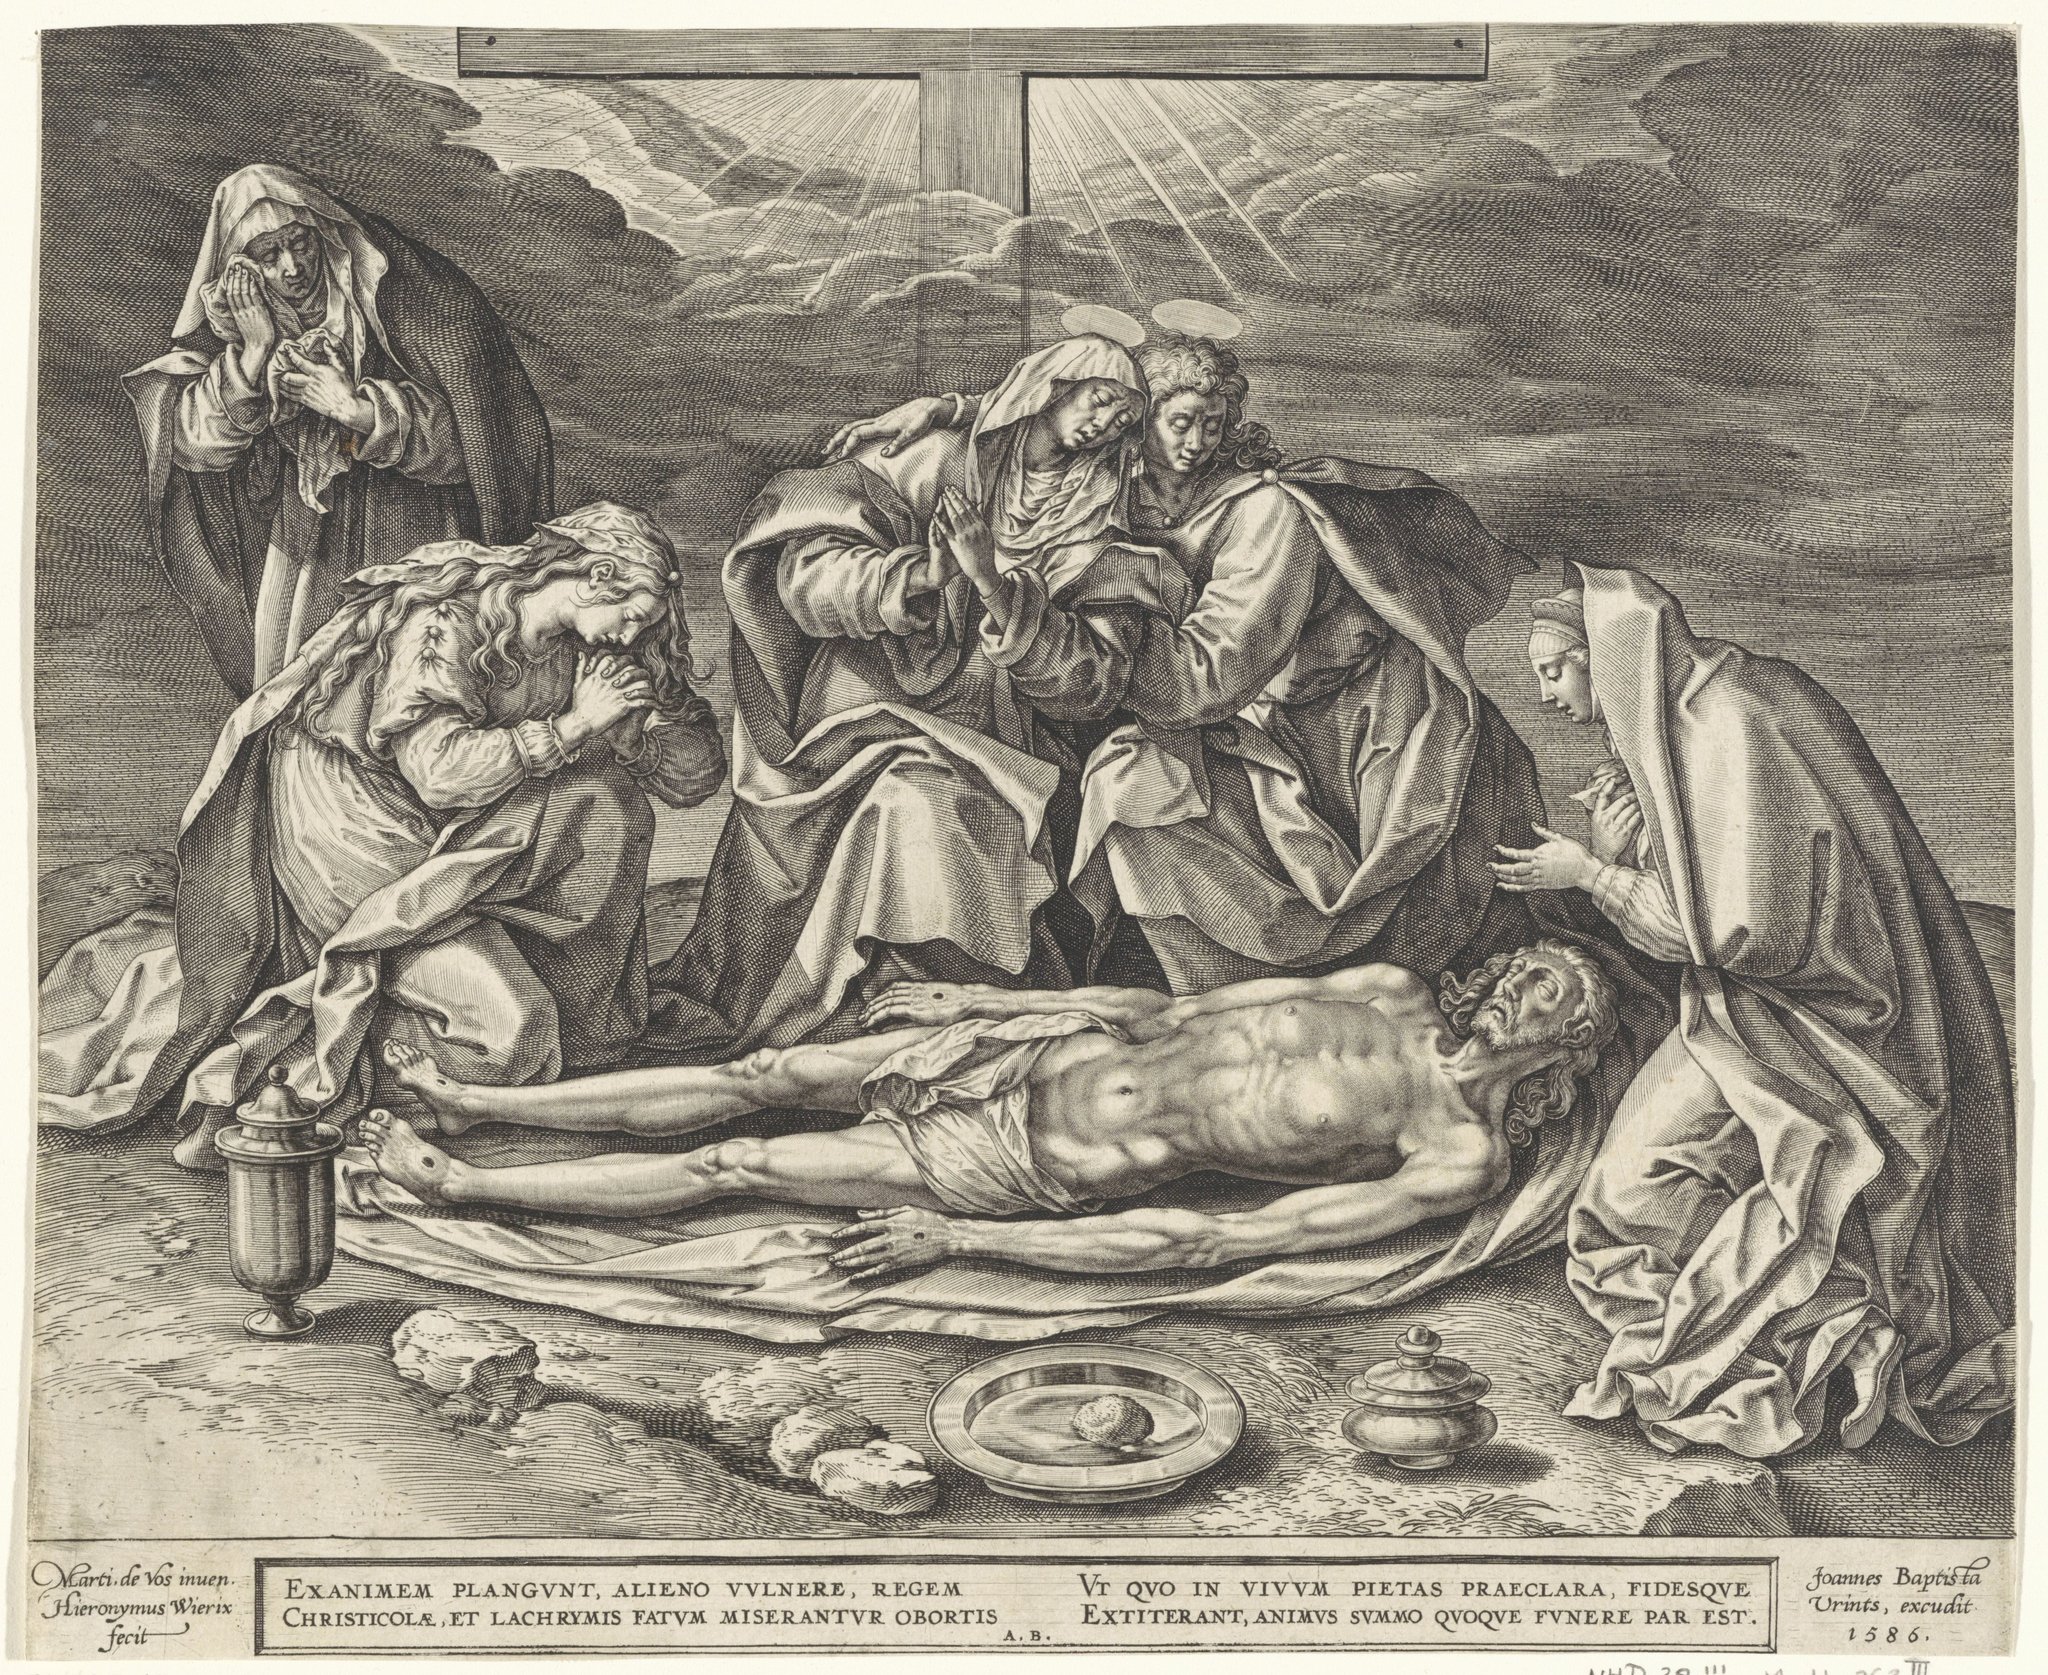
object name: print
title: Bewening van Christus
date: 1586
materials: paper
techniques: engraving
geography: antwerp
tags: christ's body lying on the ground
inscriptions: collector's mark: Lugt 2228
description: Het lichaam van Christus ligt op een lijkwade aan de voet van het kruis. Maria, Johannes, Maria Magdalena en twee vrouwen treuren bij het lichaam. In het kader in de marge een vierregelig onderschrift, in twee kolommen, in het Latijn.